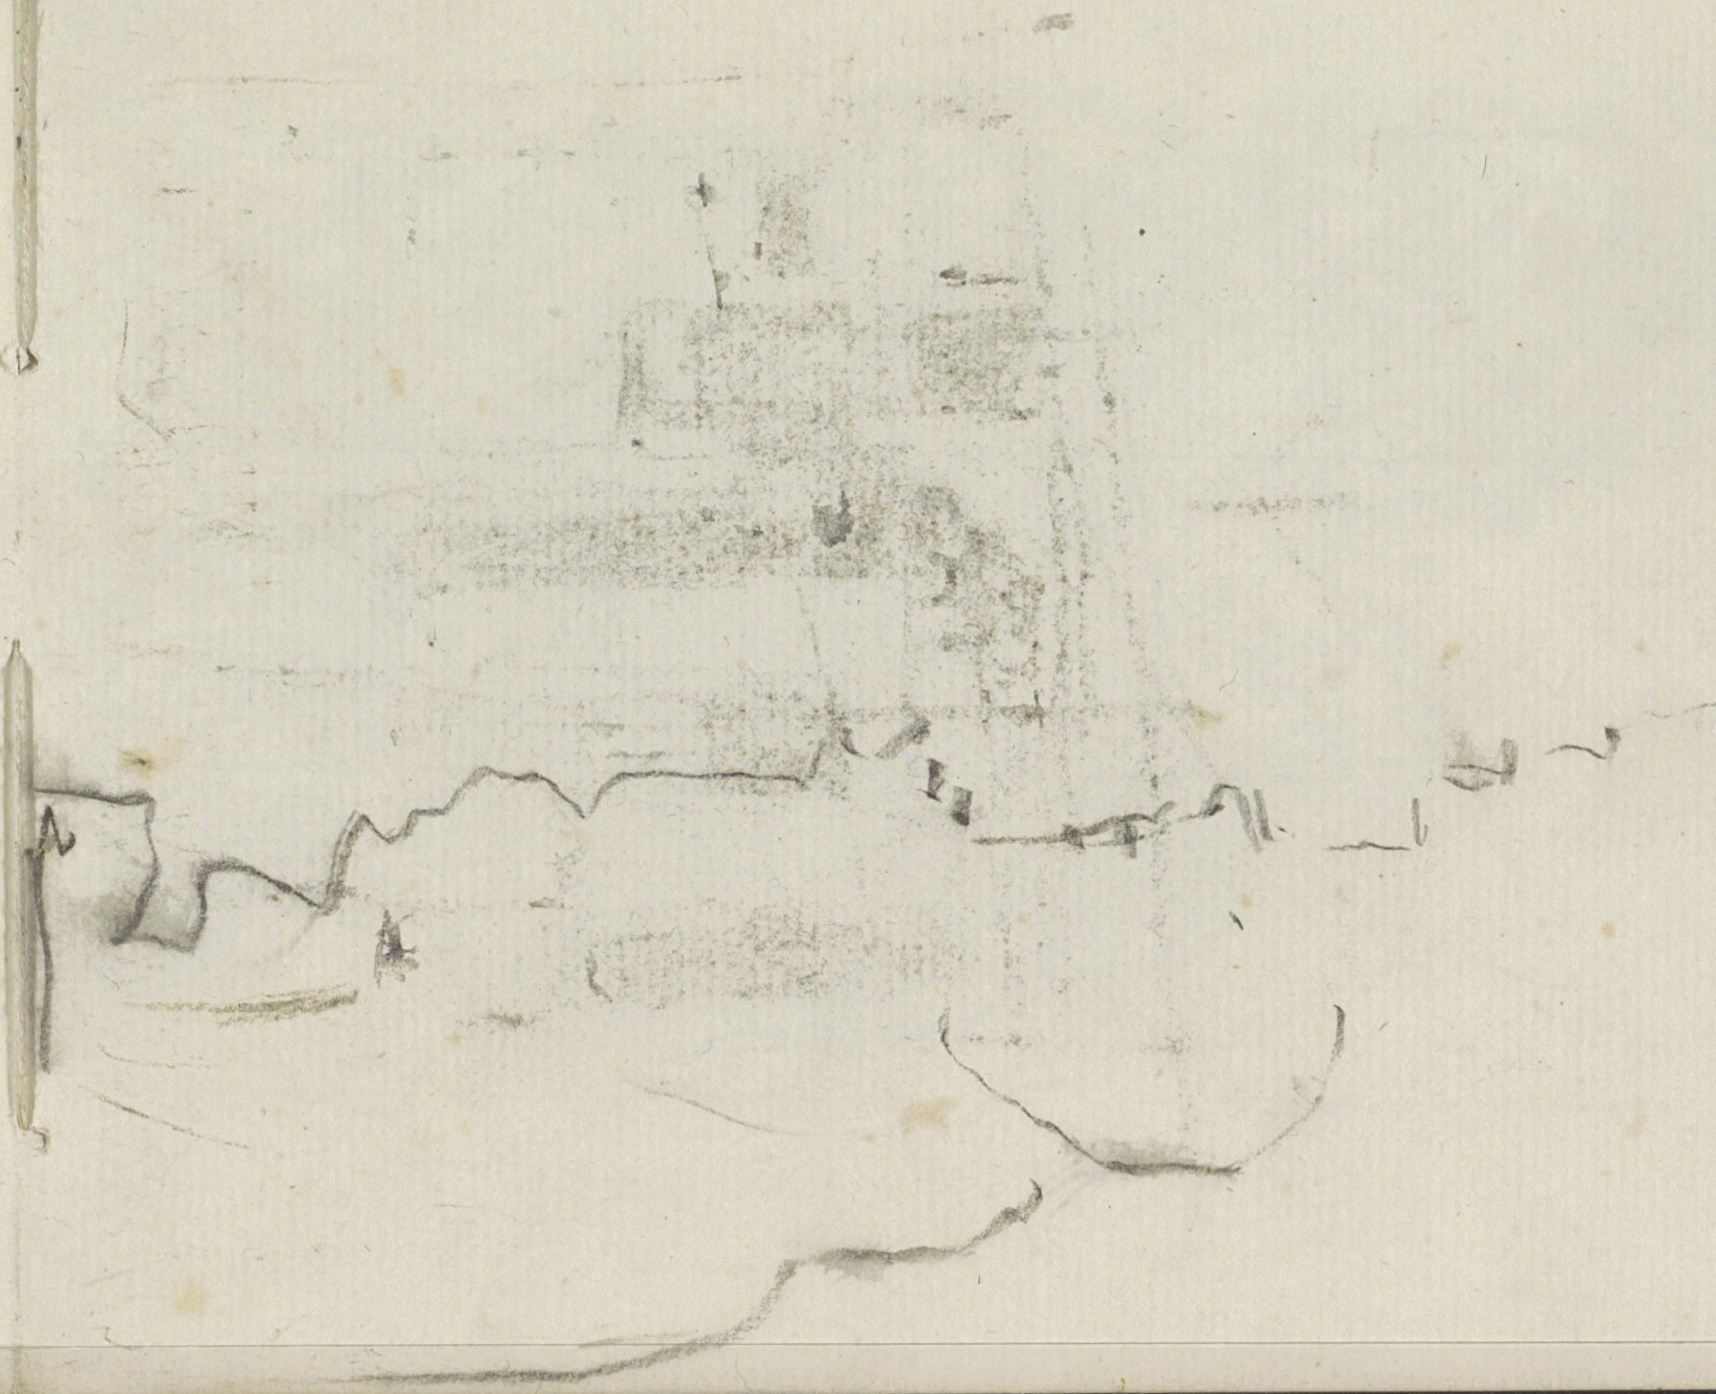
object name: sketchbook leaf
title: Stadssilhouet, mogelijk Amsterdam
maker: willem witsen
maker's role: draughtsman, painter, print maker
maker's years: 1860-1923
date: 1915-1920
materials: chalk, paper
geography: amsterdam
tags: city-view, and landscape with man-made constructions, amsterdam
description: Blad 6 recto uit een schetsboek met 23 bladen.